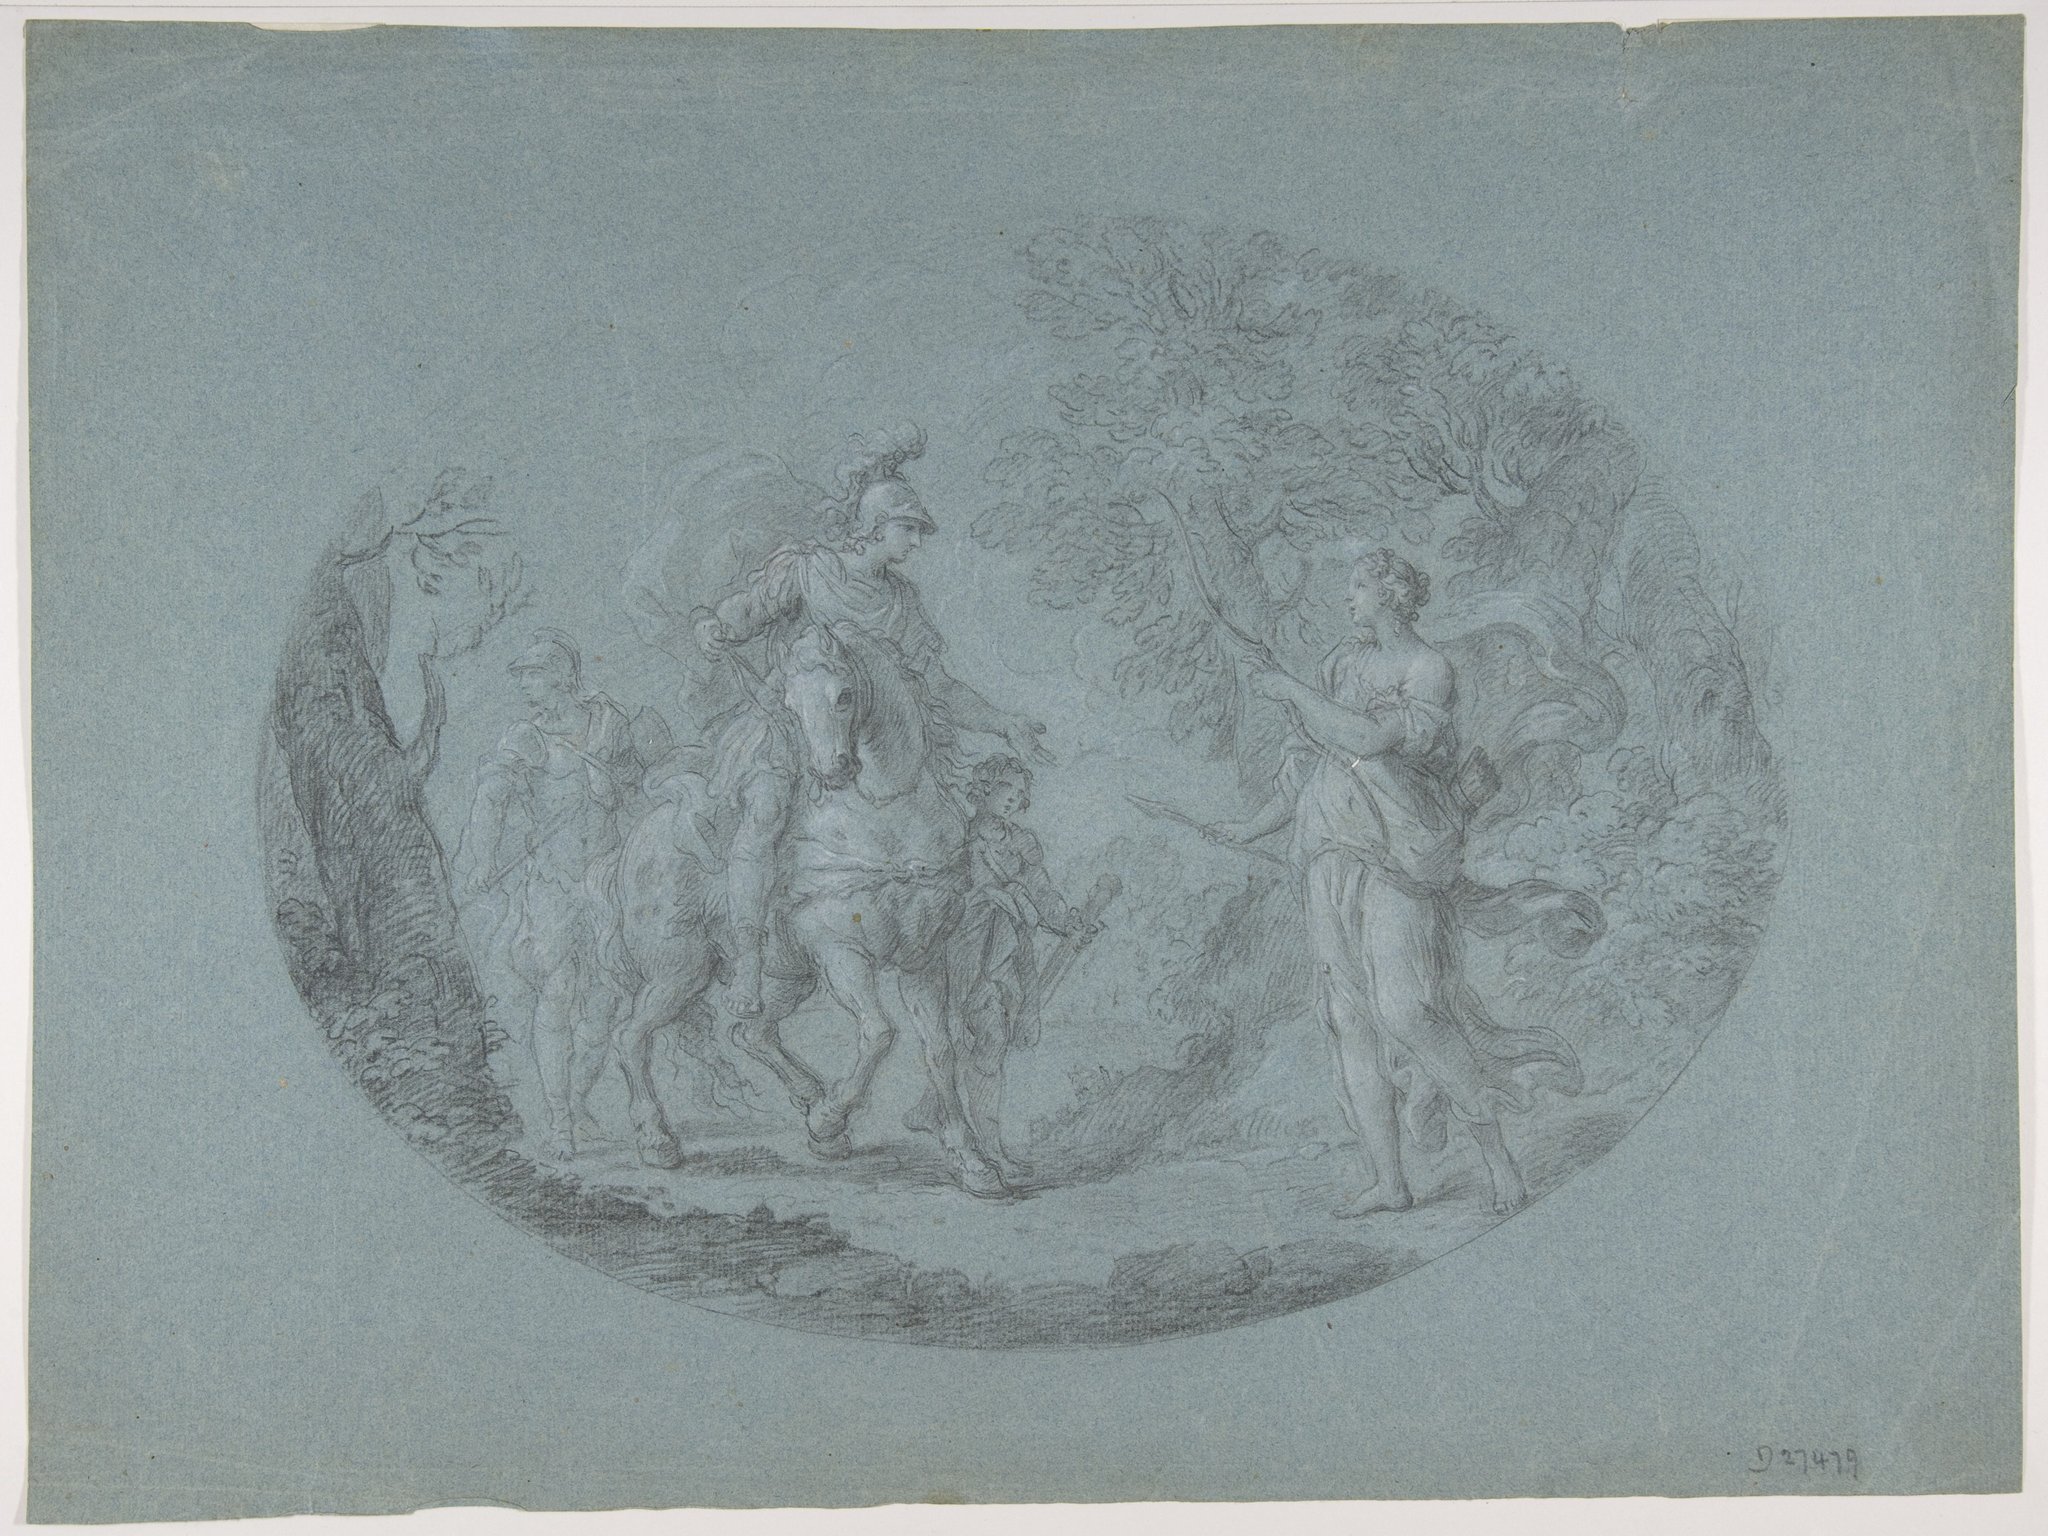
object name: drawing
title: Venus Disguised as a Huntress Appears to Aeneas (Aeneid I: 305 ff.)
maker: stefano pozzi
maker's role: artist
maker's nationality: italian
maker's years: 1699-1768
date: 1699-1768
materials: chalk, paper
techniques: highlighting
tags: aeneas,venus,horses,trees